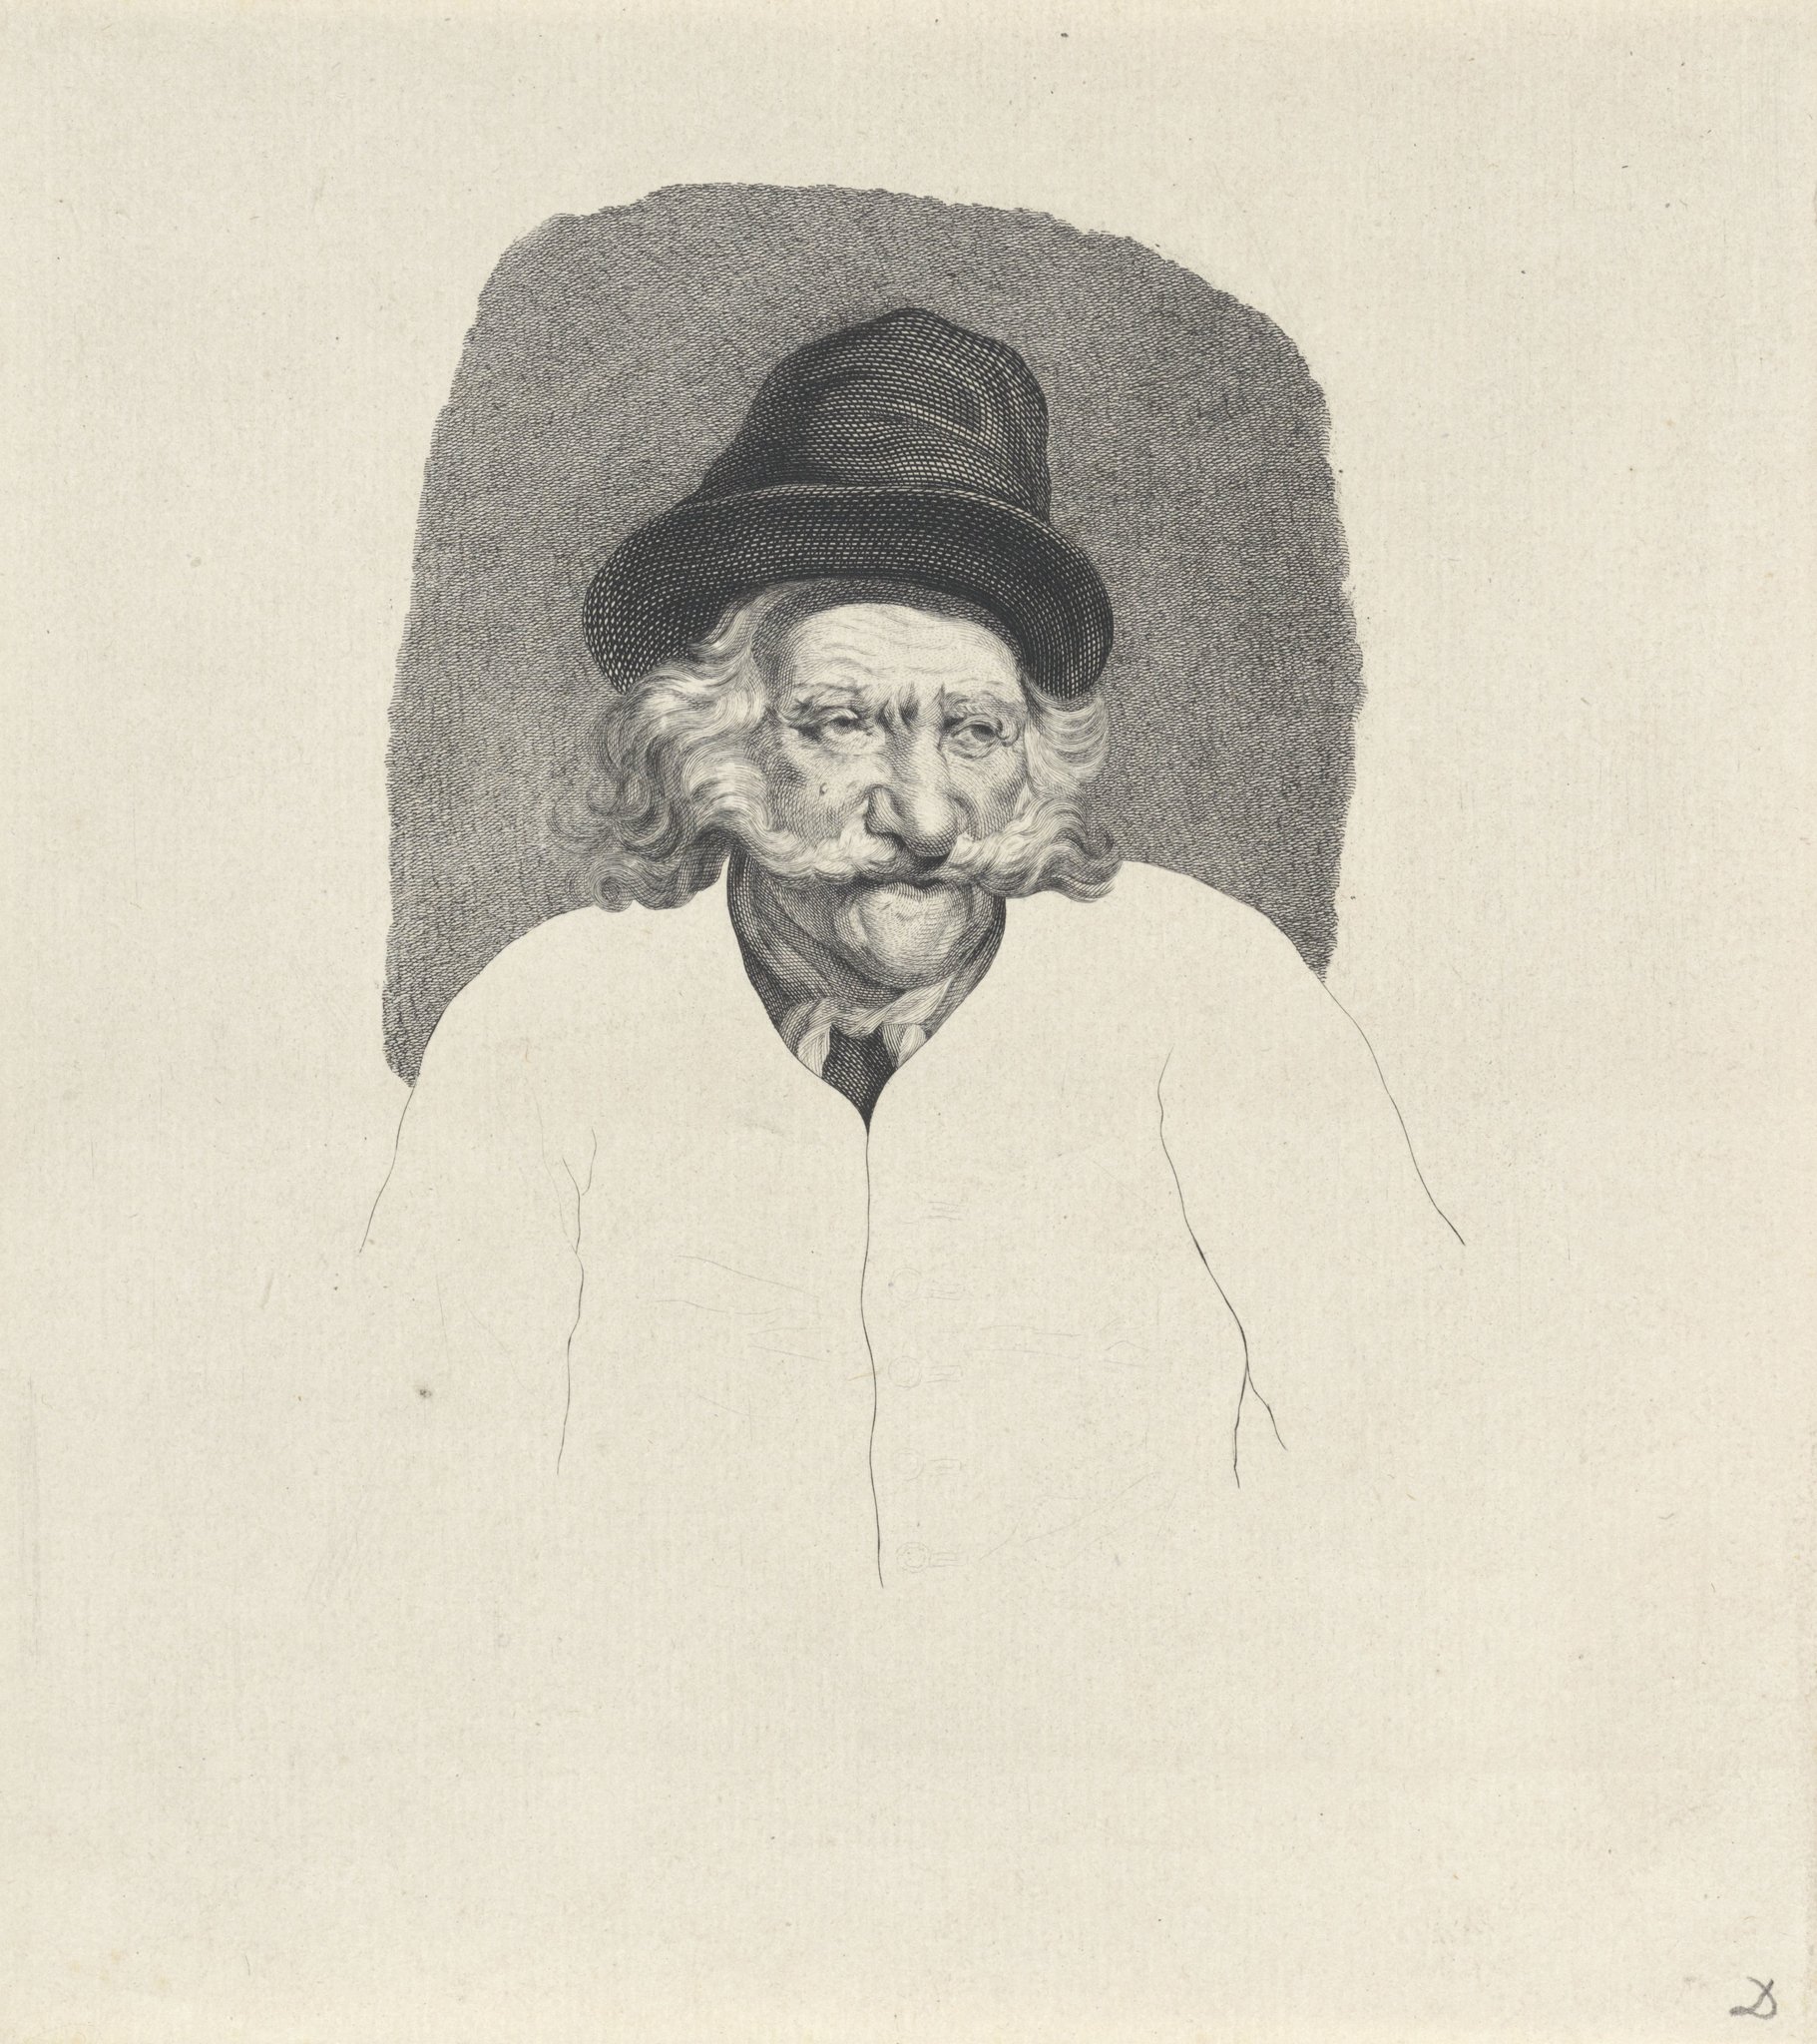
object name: print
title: Portret van Jan Kuiper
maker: reinier vinkeles (i)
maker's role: draughtsman, print maker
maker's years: 1741-1816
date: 1745-1816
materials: paper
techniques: engraving, etching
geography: amsterdam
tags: jan kuiper (jan practiseer)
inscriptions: collector's mark: Lugt 2228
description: Portret van Jan Kuiper, bijgenaamd Jan Practiseer.